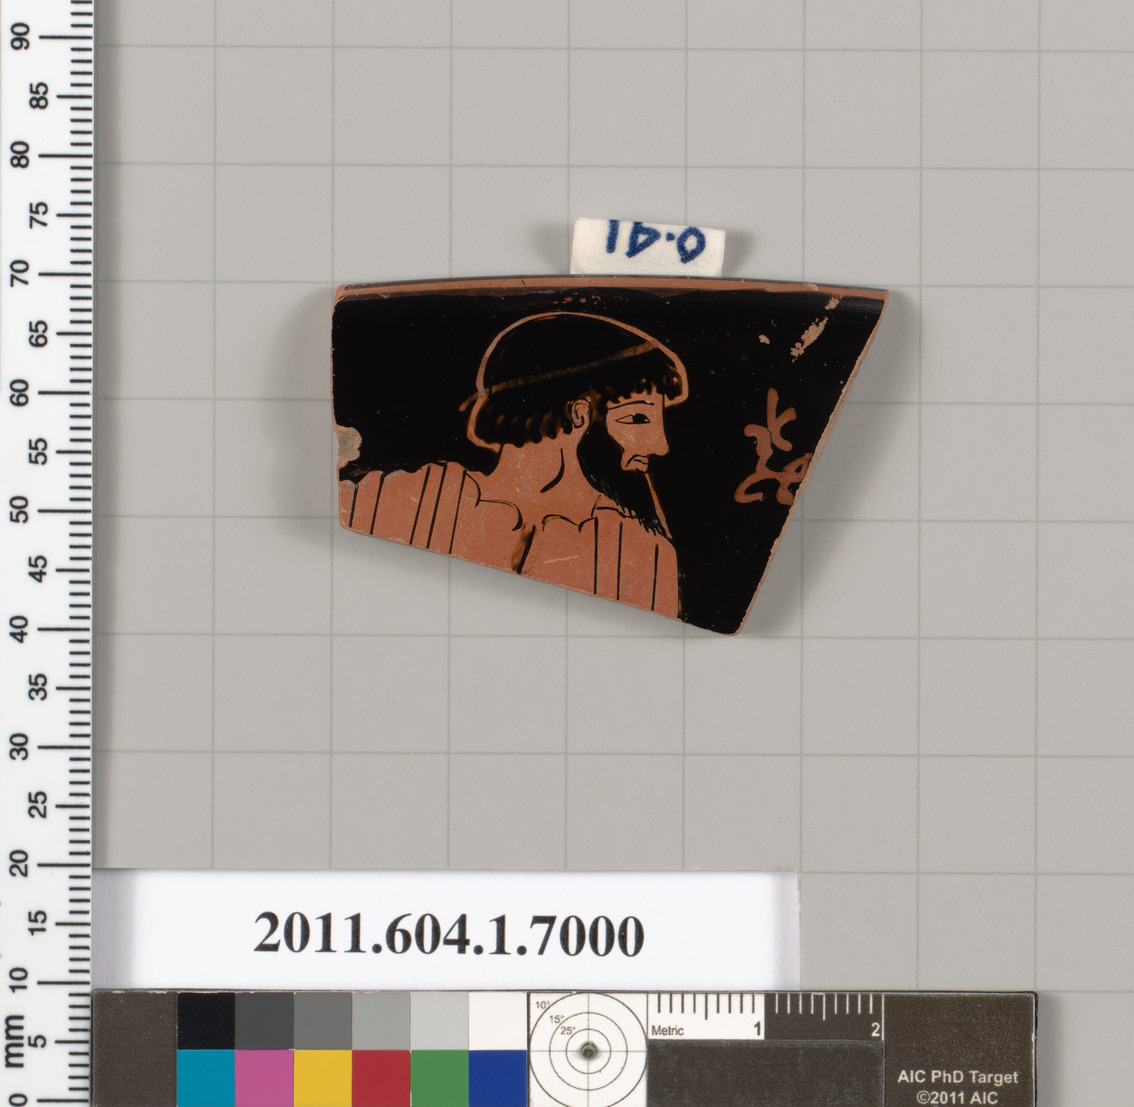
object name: kylix fragment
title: Terracotta rim fragment of a kylix (drinking cup)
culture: greek, attic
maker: painter of london e 55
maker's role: artist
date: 500-480 BCE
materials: terracotta